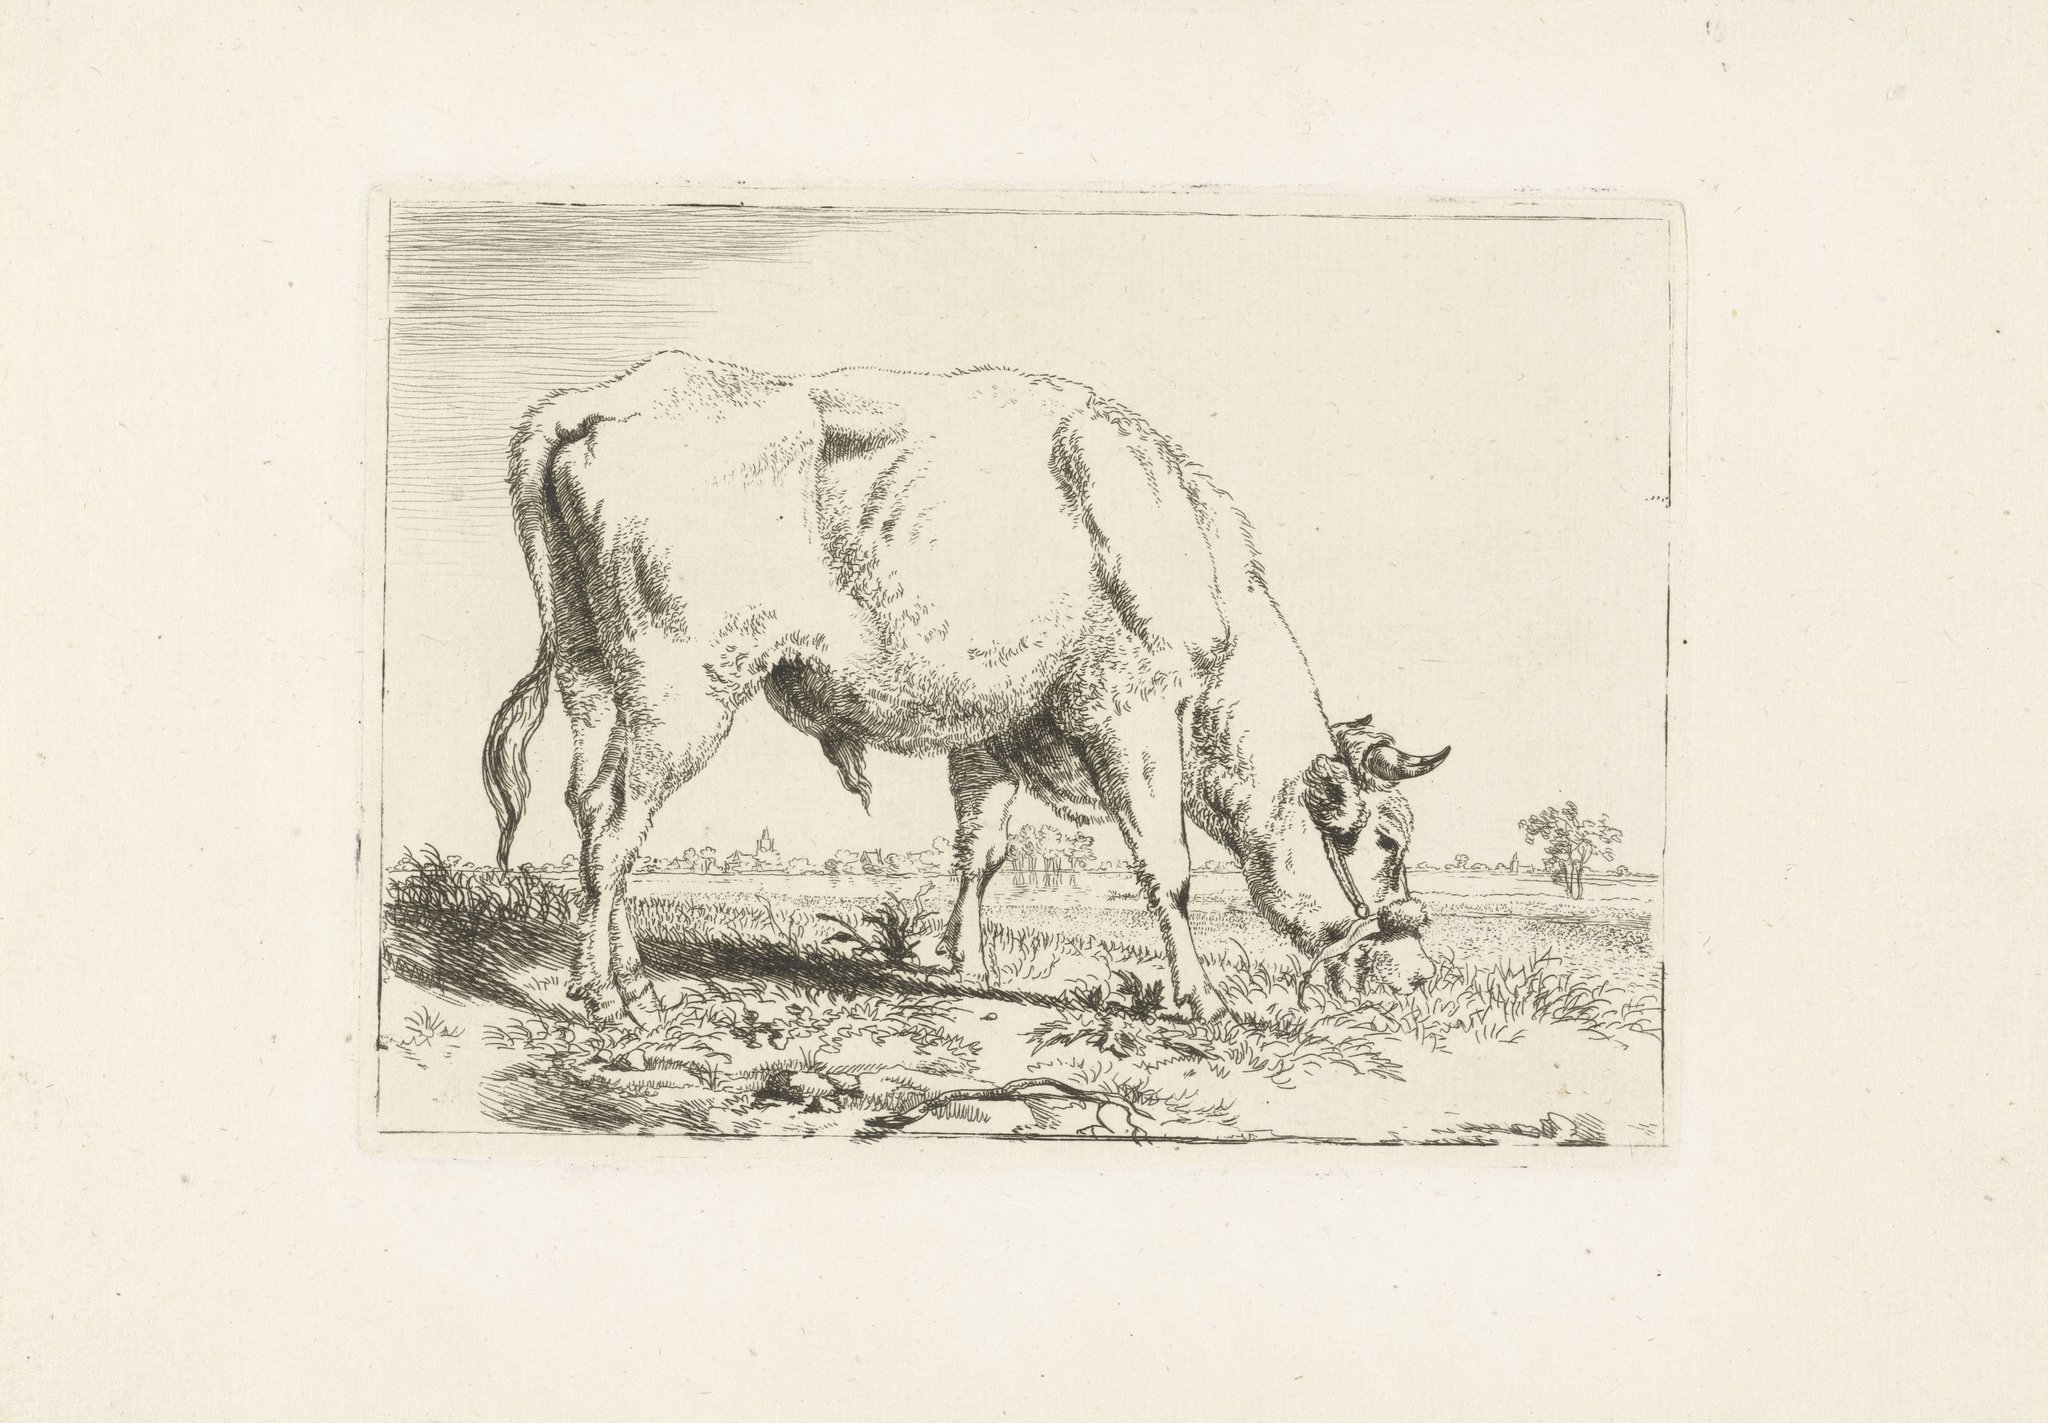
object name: print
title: Grazende stier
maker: pieter gerardus van os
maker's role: draughtsman, painter, print maker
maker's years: 1776-1839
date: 1798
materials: paper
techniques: etching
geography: netherlands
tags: bull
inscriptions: collector's mark: Lugt 2228